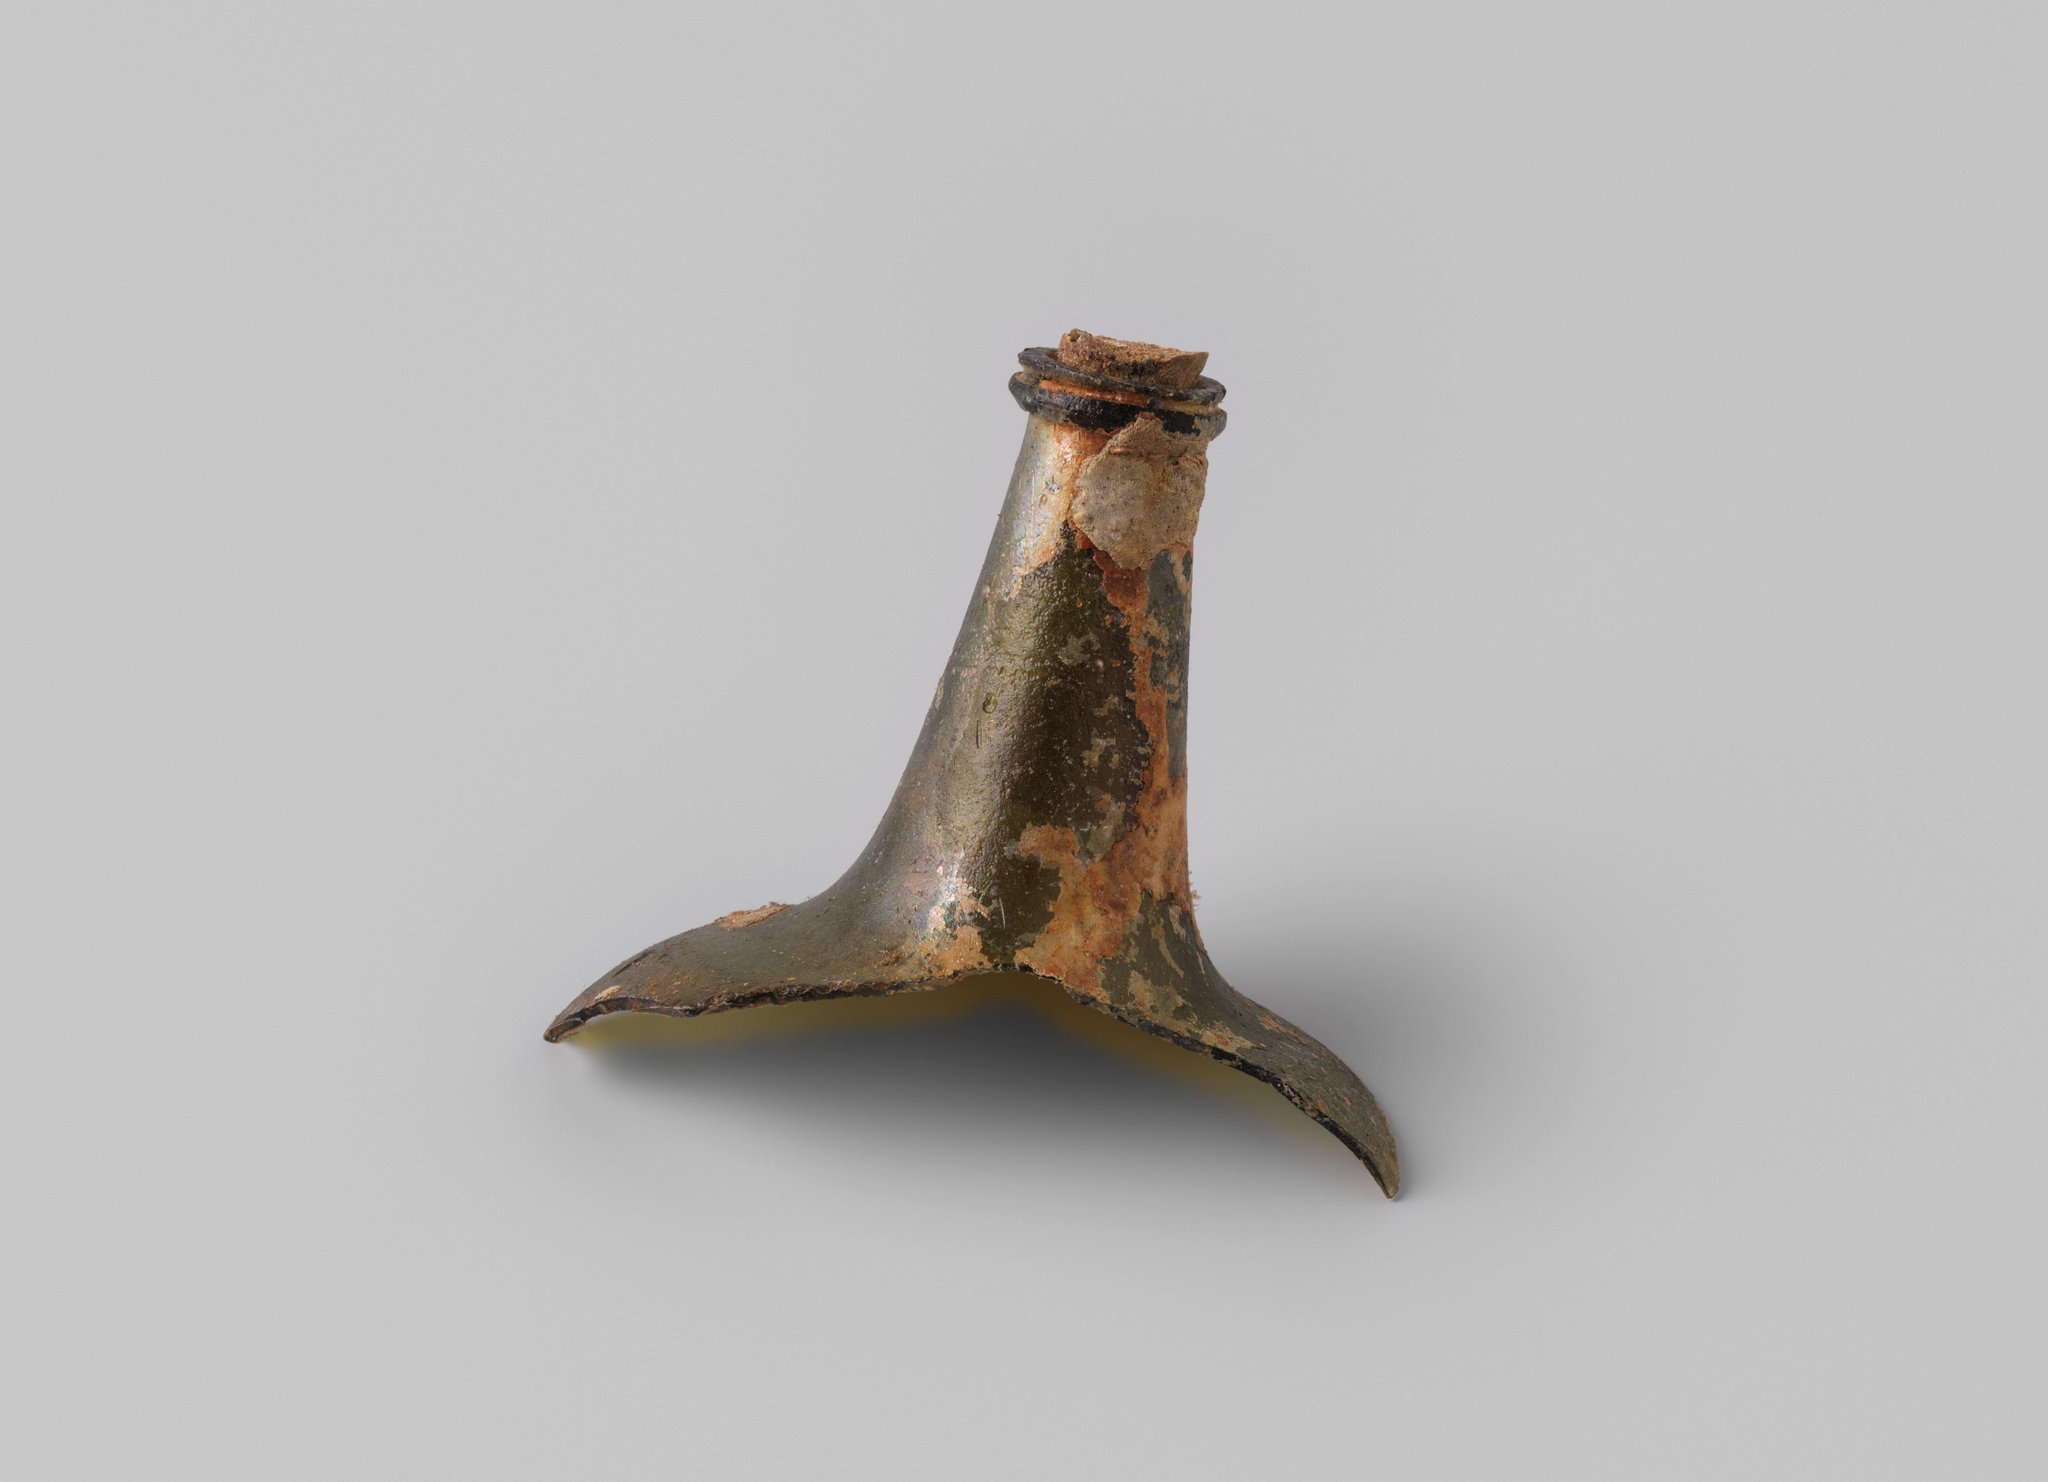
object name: neck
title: Hals met kurk van een wijnfles uit het wrak van de Oost-Indiëvaarder Hollandia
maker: Anonymous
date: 1700-1743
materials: cork, glass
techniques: green glass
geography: netherlands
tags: verenigde oostindische compagnie, hollandia (schip), annet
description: Wine bottle, continental production, neck, onion-shaped bottle or bottle with vertical side; eroded, vs-string rim, with cork